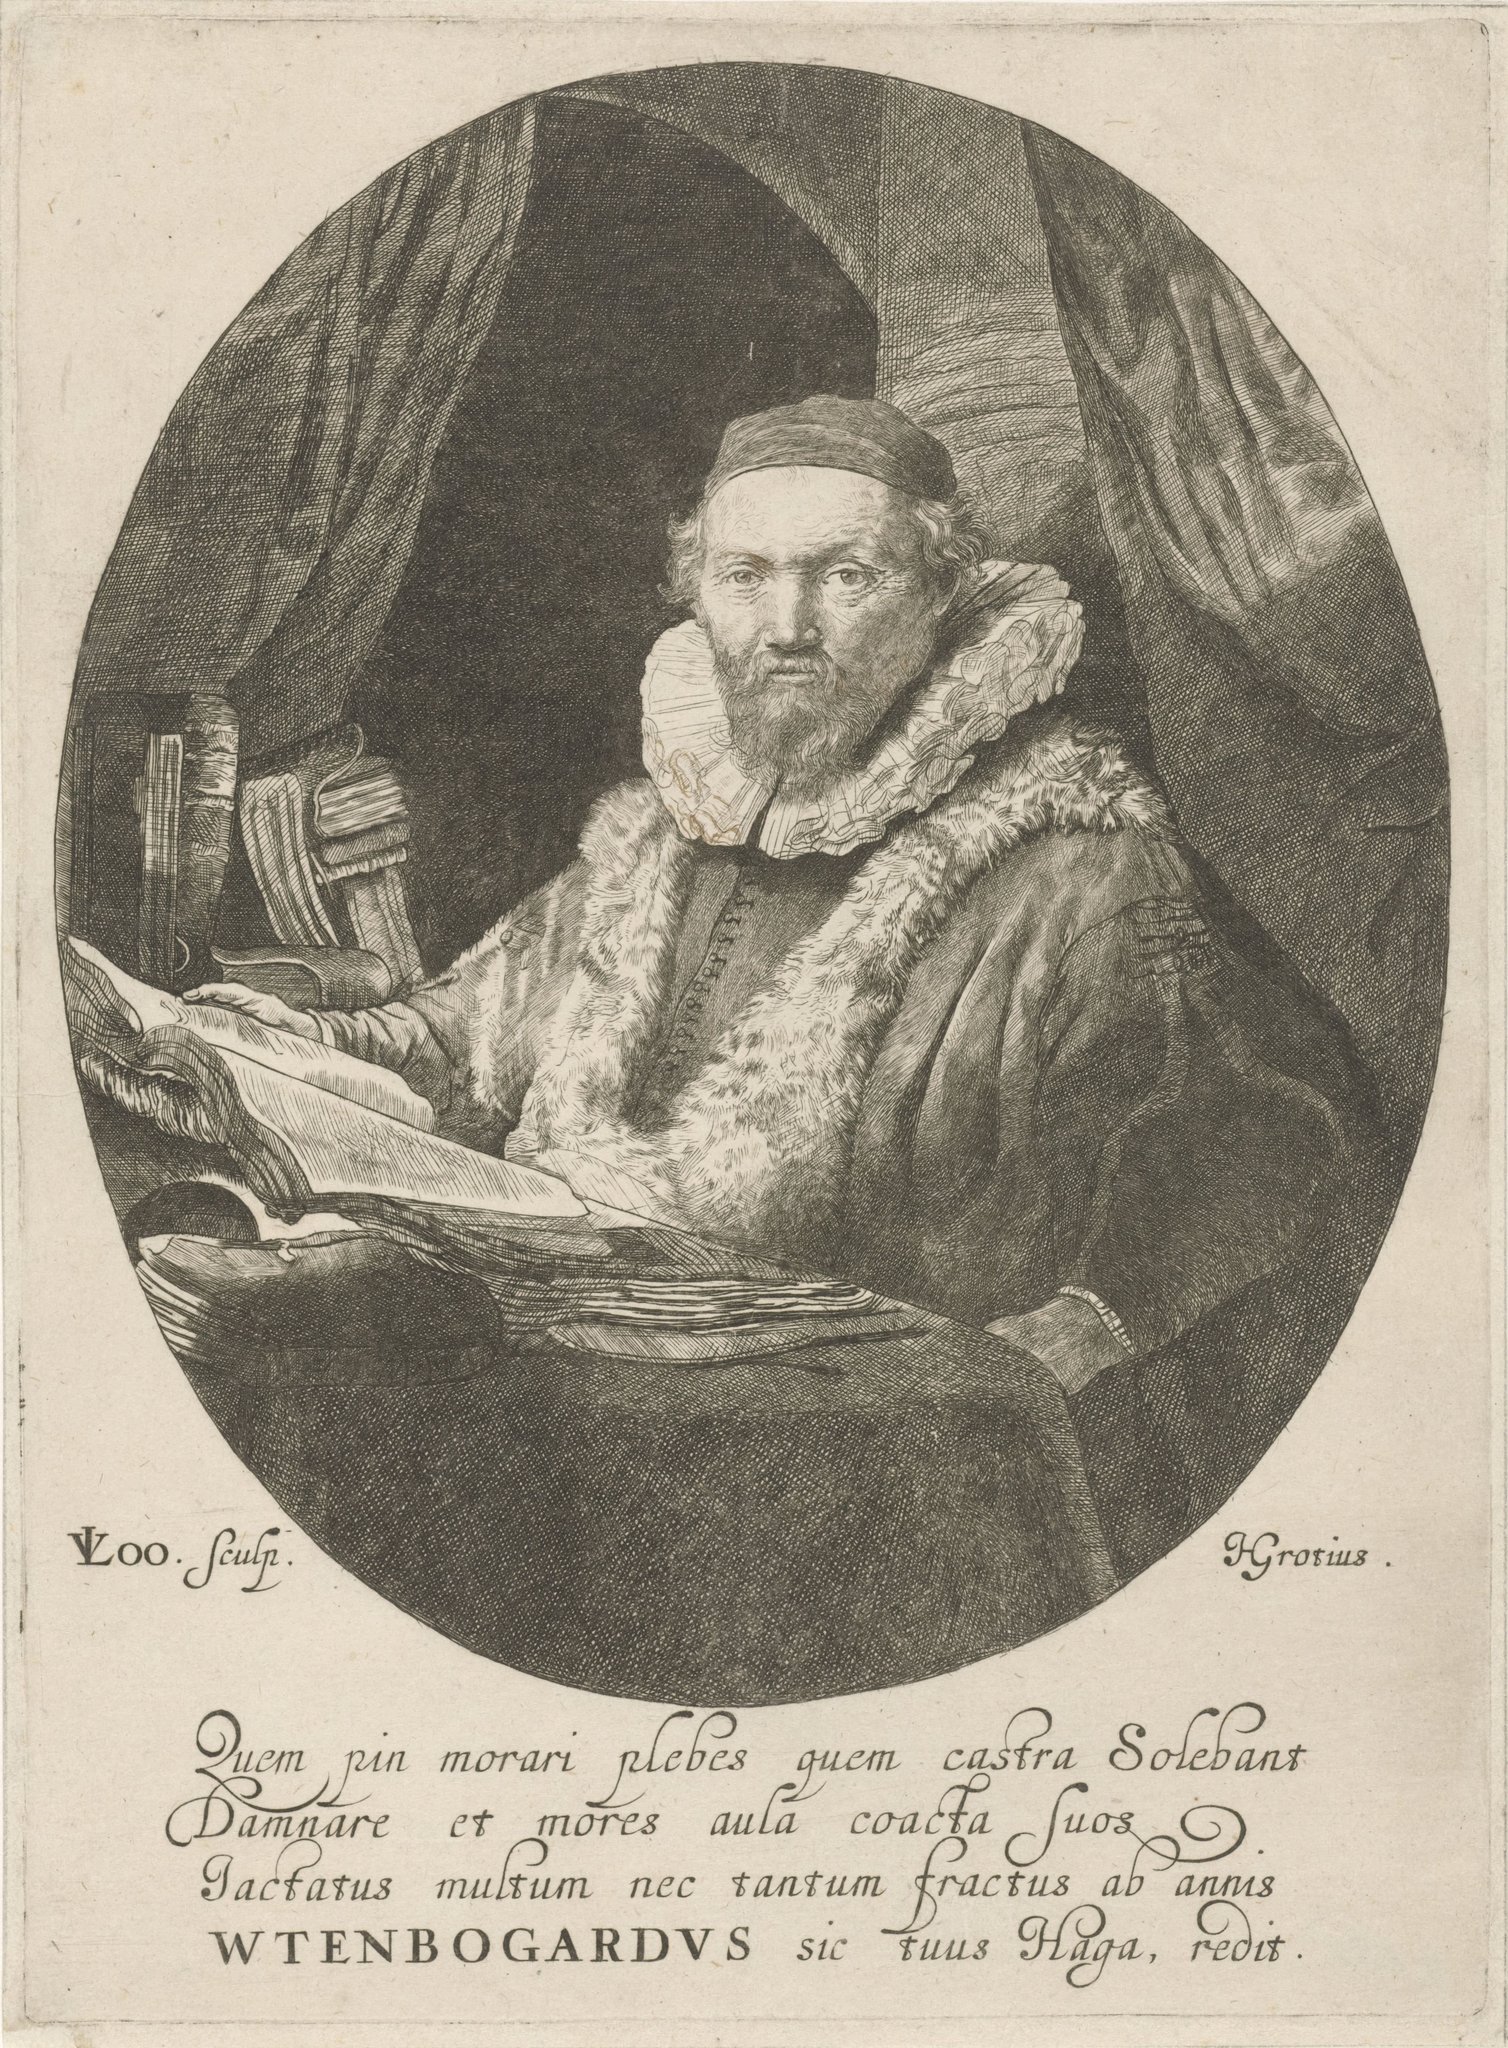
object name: print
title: Portret van Johannes Wtenbogaert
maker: jacob van loo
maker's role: painter, print maker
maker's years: 1614-1670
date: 1624-1670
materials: paper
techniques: etching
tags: the hague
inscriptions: collector's mark: Lugt 2228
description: Portret van de predikant Johannes Wtenbogaert. Aan het eind van de zestiende eeuw werd hij hofpredikant van stadhouder prins Maurits.